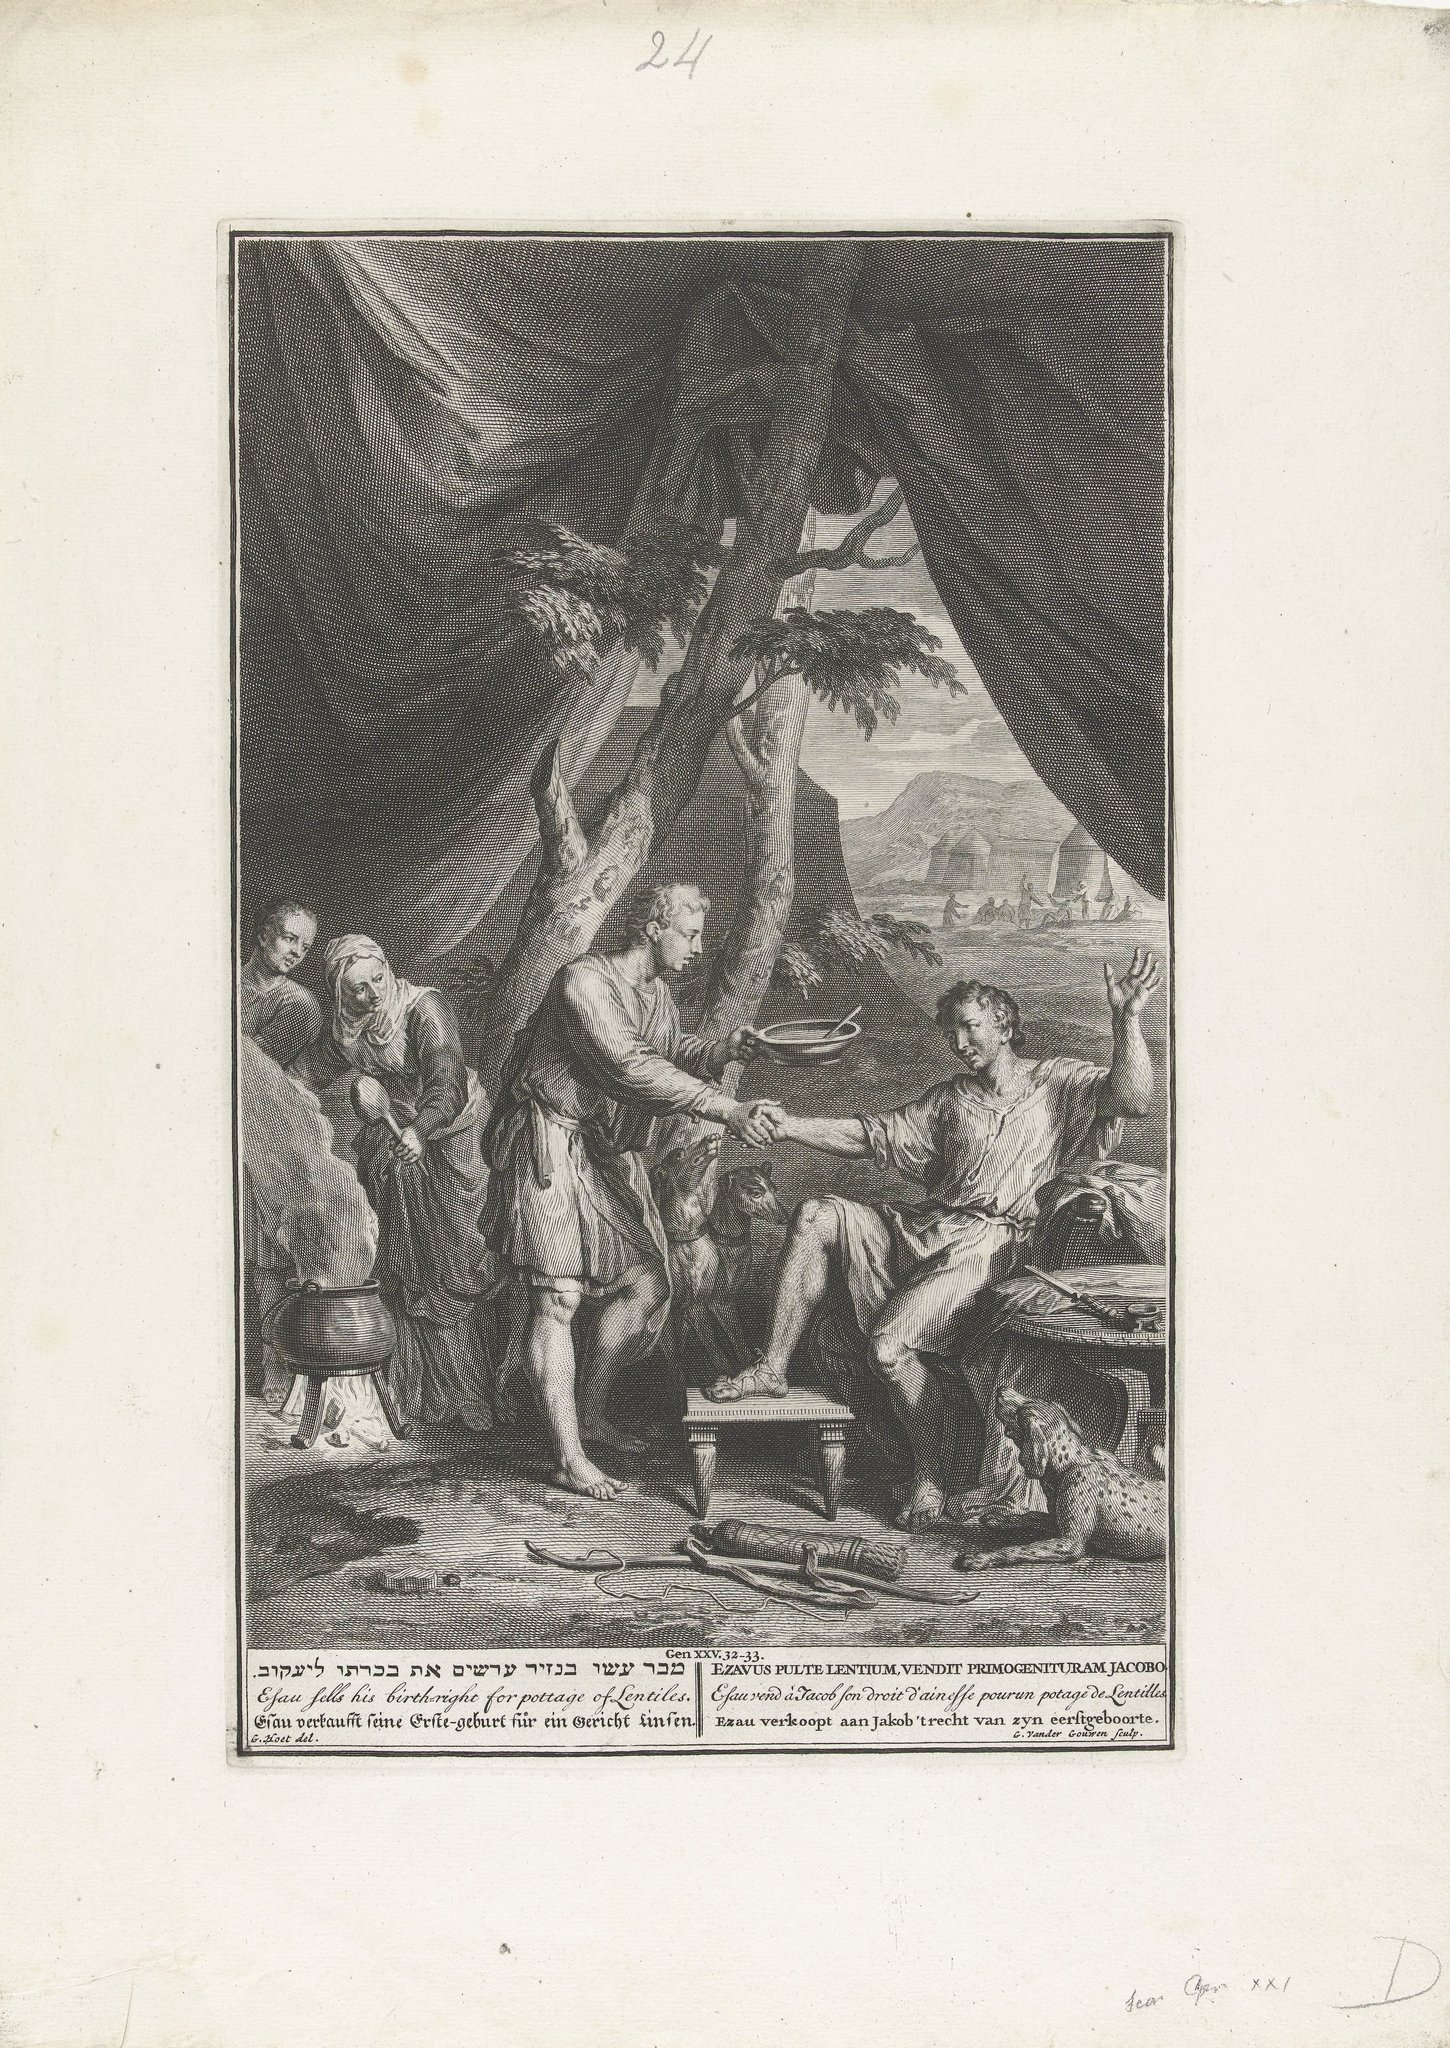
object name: book illustration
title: Esau verkoopt zijn eerstgeboorterecht aan Jakob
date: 1728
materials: paper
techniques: engraving, etching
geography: amsterdam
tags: esau, returning hungry from the hunt, sells his first birthright to jacob for a pottage of lentils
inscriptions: collector's mark: Lugt 2228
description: Esau verkoopt zijn eerstgeboorterecht aan Jakob voor een bord linzen. Jakob overhandigt hem het bord (Gen. 25:32-33). De prent heeft een Hebreeuws, Latijns, Frans, Engels, Duits en Nederlands onderschrift.